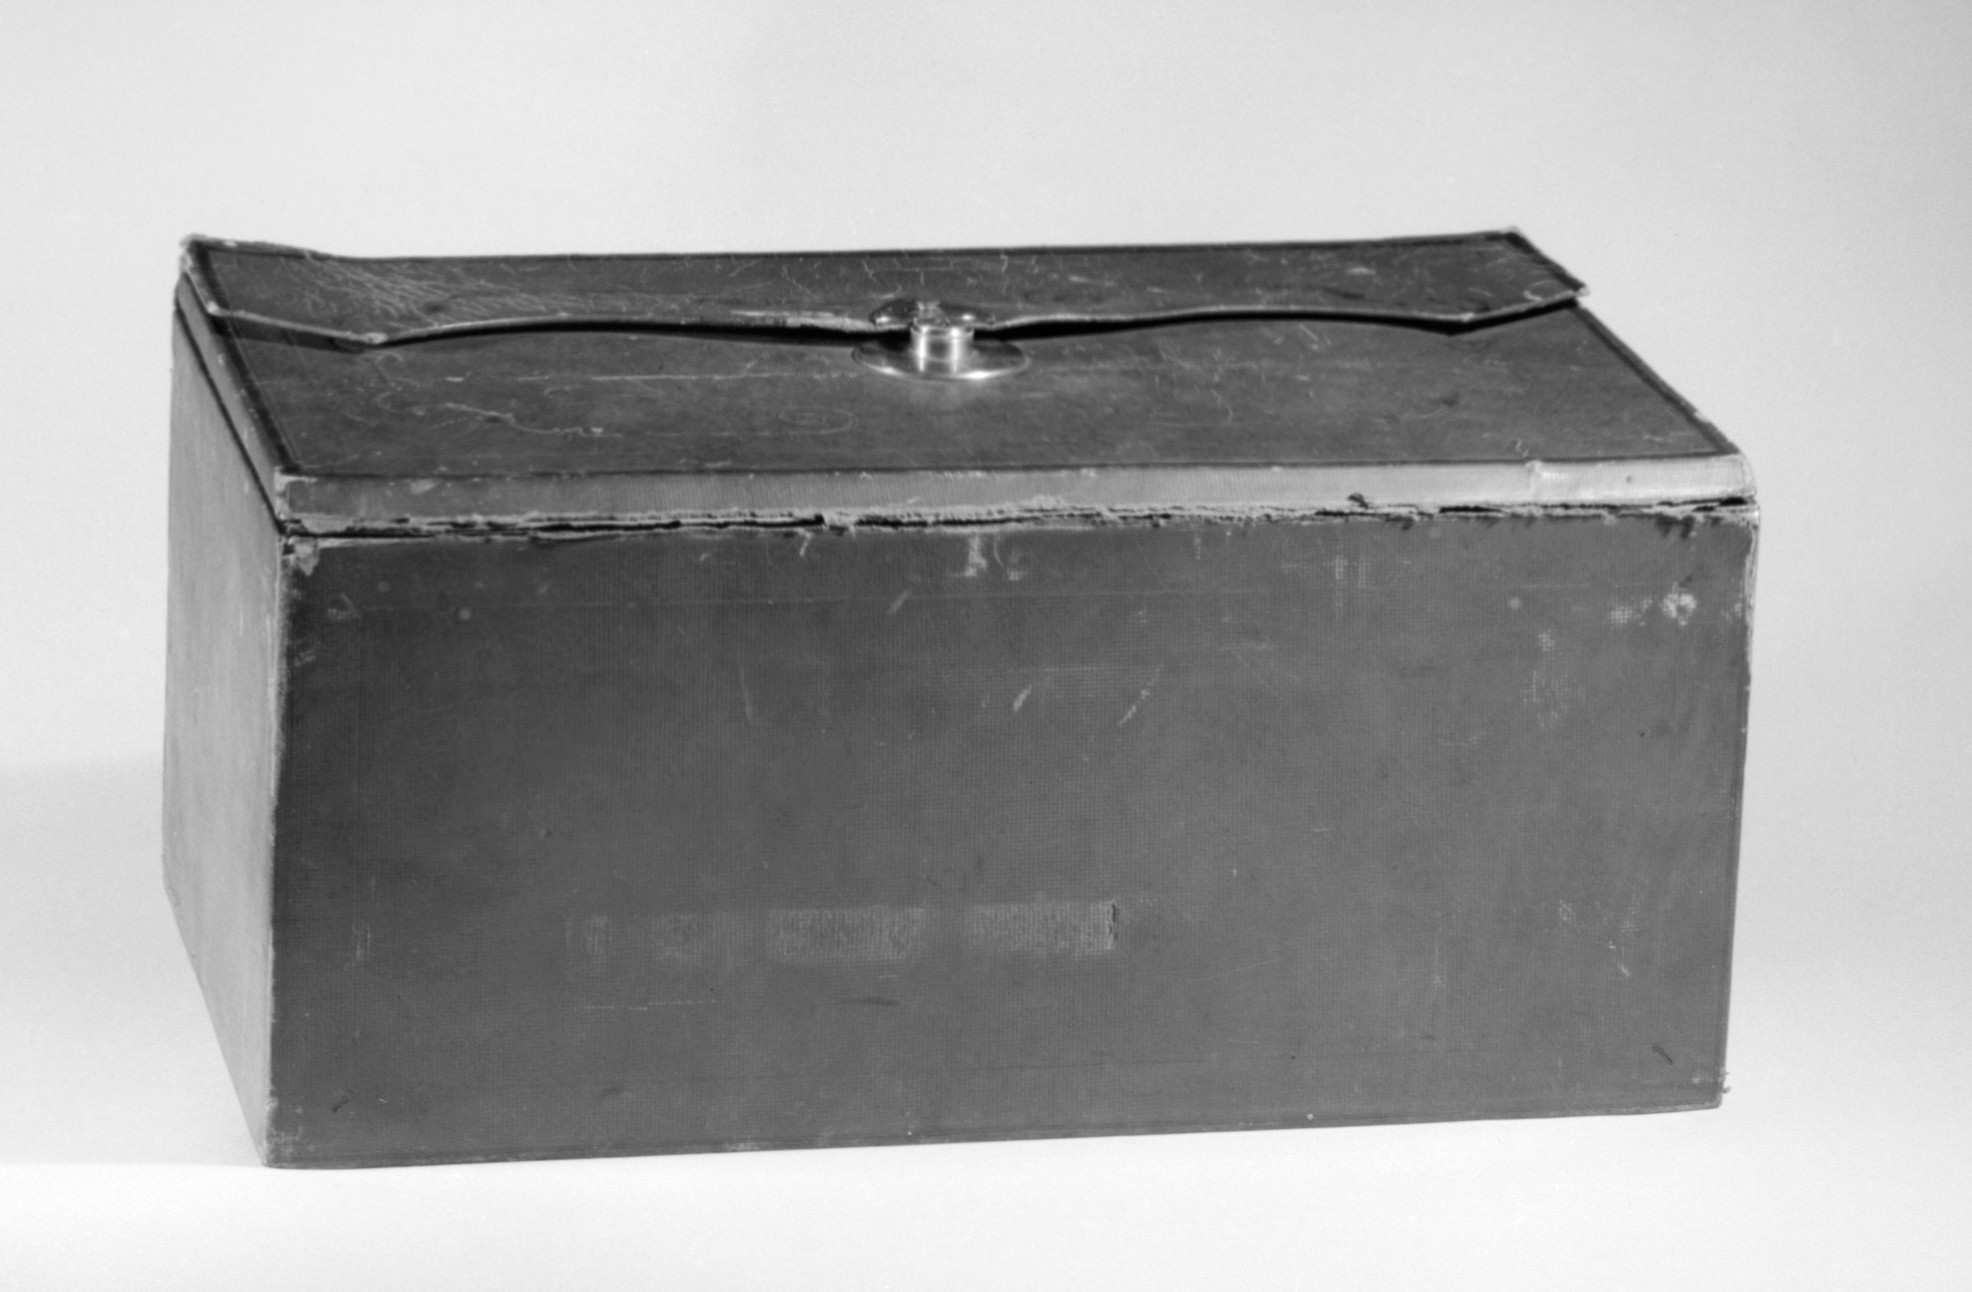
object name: case with tray and drawer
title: Case with tray and drawers (part of a set)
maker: ibm, al, etc.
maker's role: maker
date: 1848-1849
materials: leather, silk